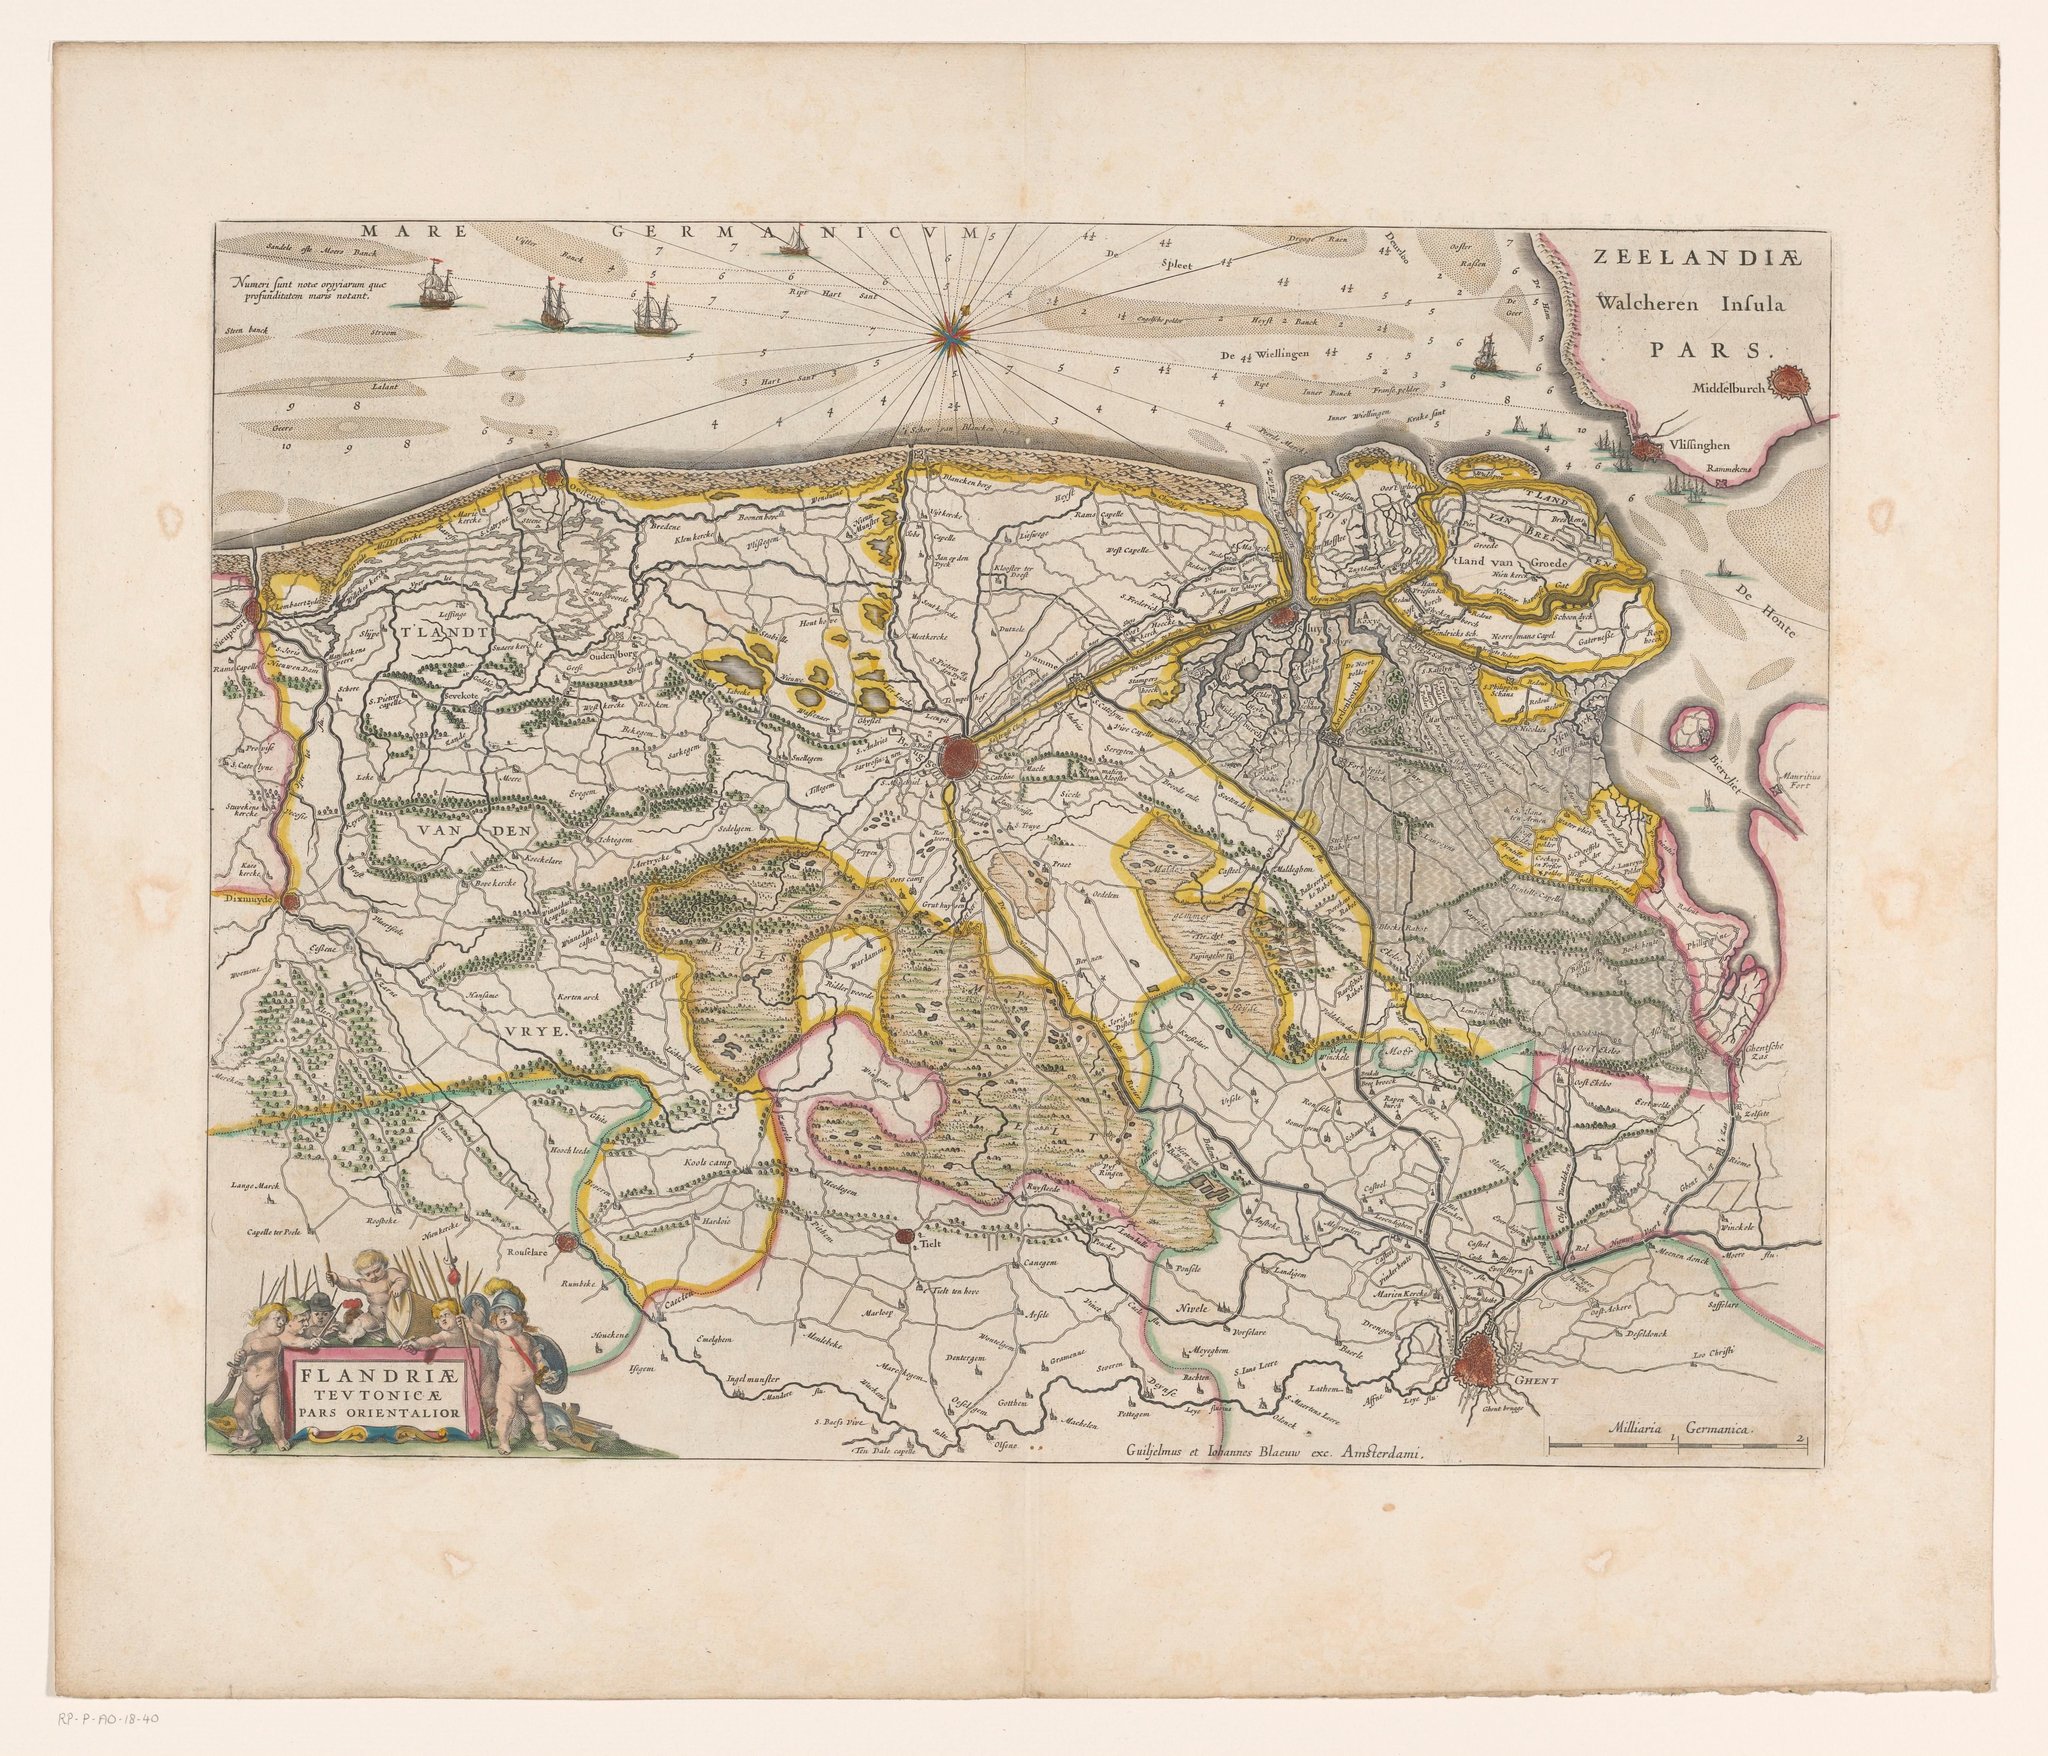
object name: map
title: Kaart van het Brugse Vrije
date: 1647-1664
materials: paper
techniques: engraving, etching, hand coloring, letterpress printing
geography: amsterdam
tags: maps of separate countries or regions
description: Prent gebruikt in: Blaeu, Willem Janszoon en Johannes Willemszoon Blaeu. Toonneel des aerdrycx, ofte nieuwe Atlas, dat is de beschryving van alle landen. 4 delen. Amsterdam: Johannes Willemszoon Blaeu, 1647-1650, dl. 1 (1647-1648). Of in: Blaeu, Willem Janszoon en Johannes Willemszoon Blaeu. Toonneel des aerdrycx, ofte nieuwe Atlas, dat is de beschryving van alle landen. 4 delen. Amsterdam: Johannes Willemszoon Blaeu, 1649-1650, dl. 1 (1649). Of in: Blaeu, Willem Janszoon en Johannes Willemszoon Blaeu. Toonneel des aerdriicx, ofte niuew Atlas, dat is beschryving van alle landen. 6 delen. Amsterdam: Johannes Willemszoon Blaeu, 1658-1661, dl. 1. Of in: Blaeu, Johannes Willemszoon. J. Blaeus grooten atlas oft wereltbeschyving, in welcke 't aerdryck, de zee, en hemel, wort vertoont en beschreven. 9 delen. Amsterdam: Johannes Willlemszoon Blaeu, 1664-1665, dl. 3 (1664).